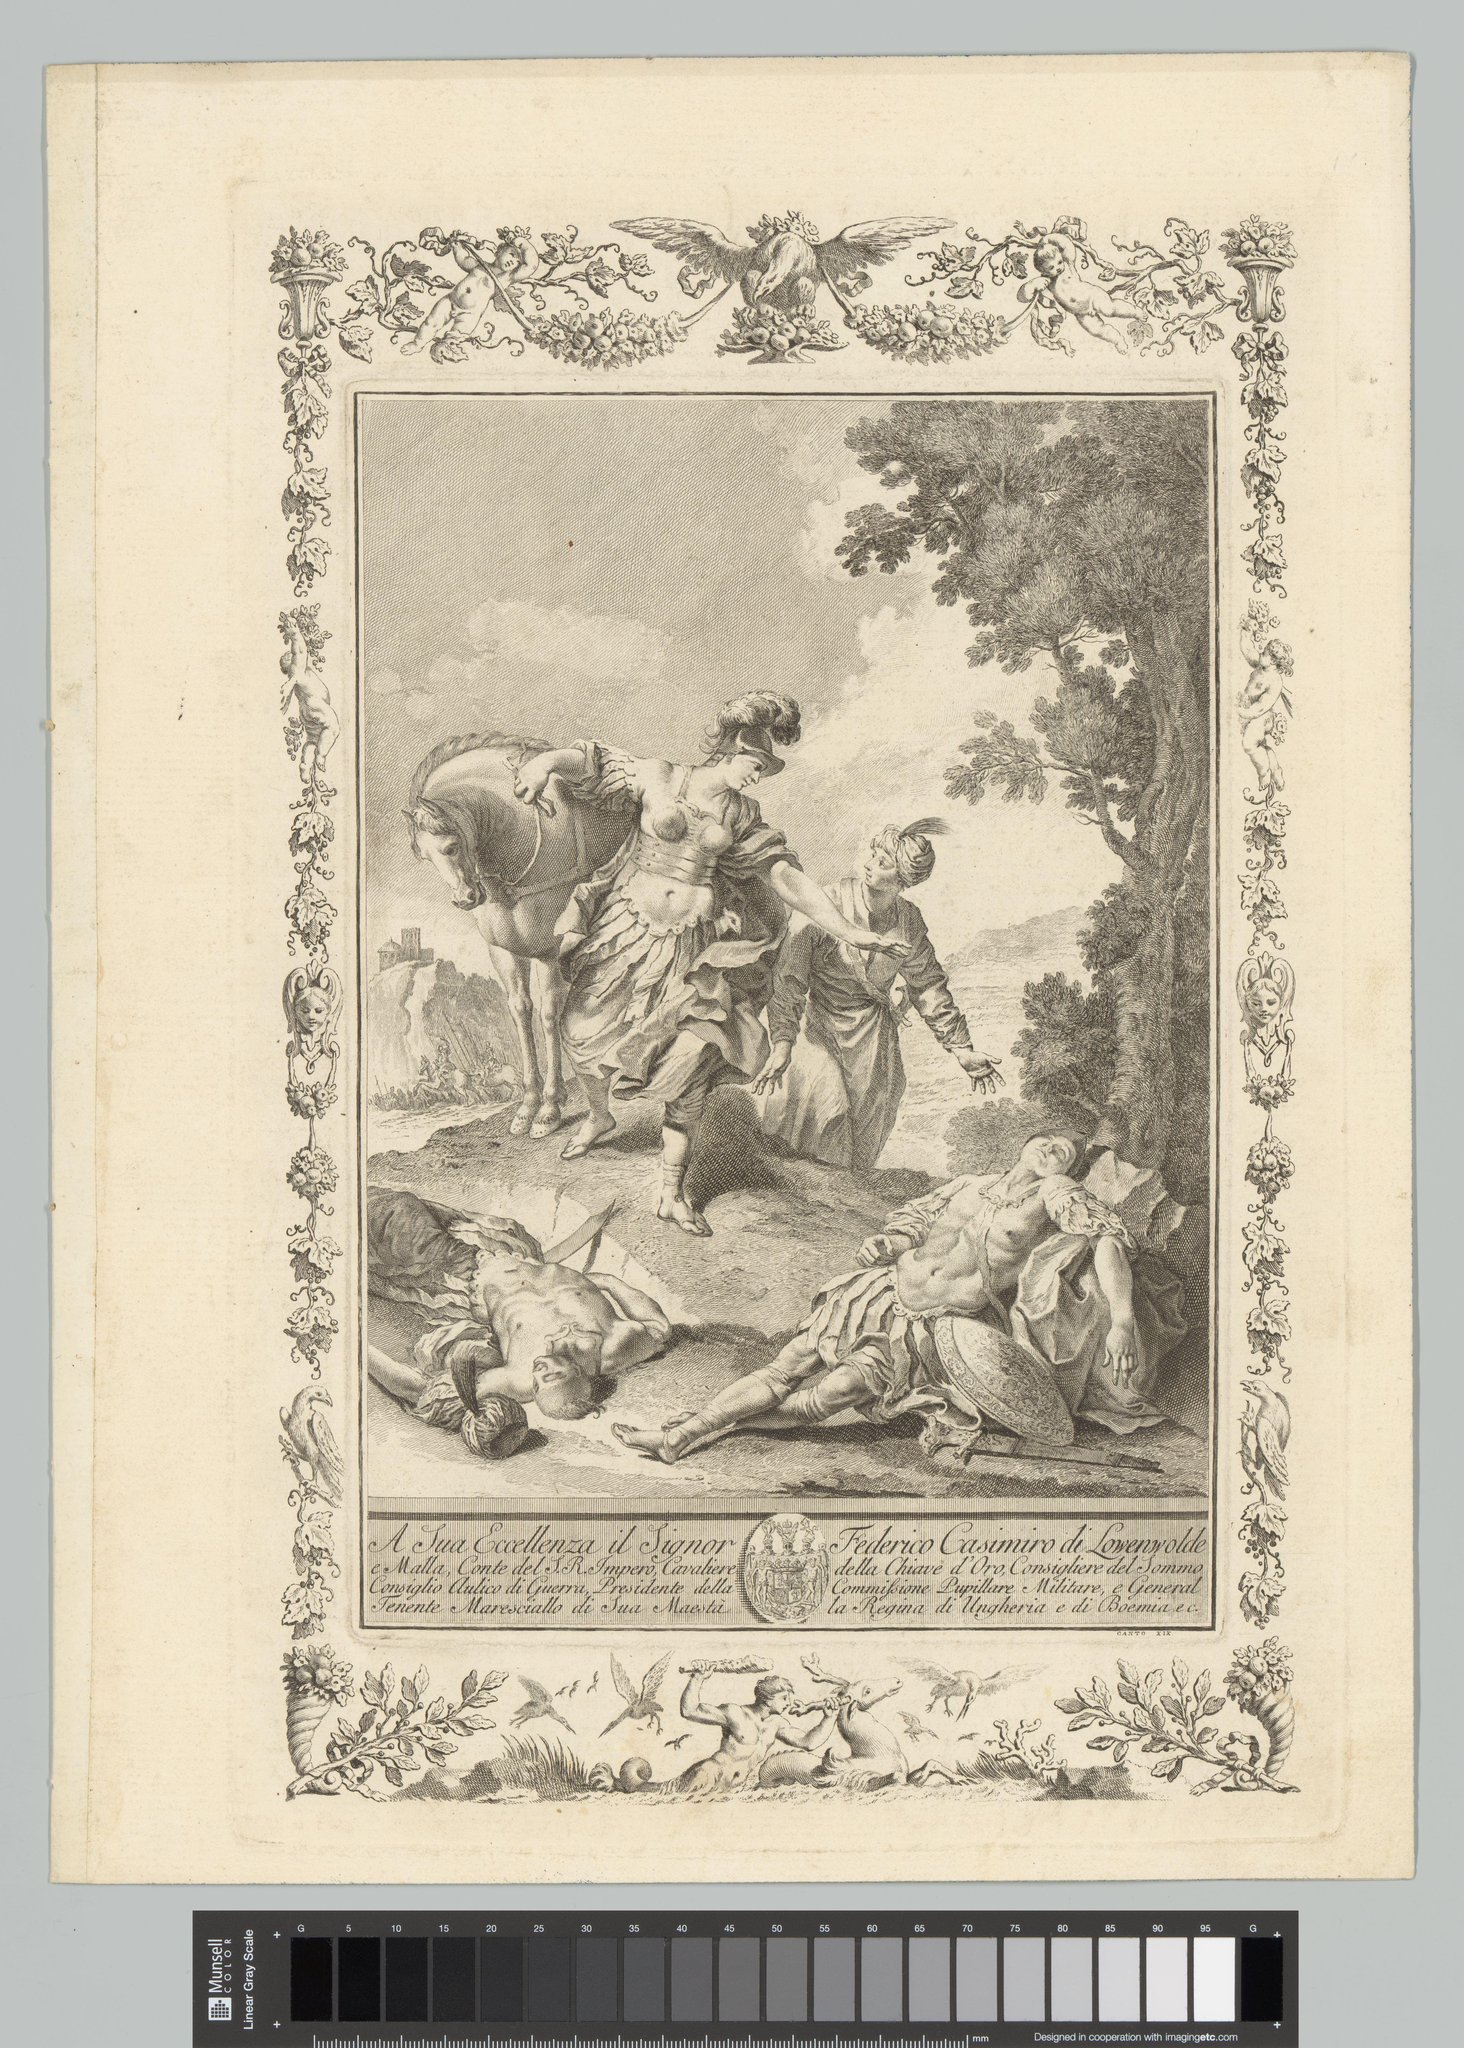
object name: print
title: Scène uit La Gerusalemme Liberata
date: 1745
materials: paper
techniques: etching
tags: fruits and vegetables ~ ornament, (scenes from) specific works of literature: tasso, gerusalemme liberata, armorial bearing, heraldry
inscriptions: collector's mark: Lugt 2228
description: Ornamentrand met bloemen, planten, een jachtscène en een adelaar.